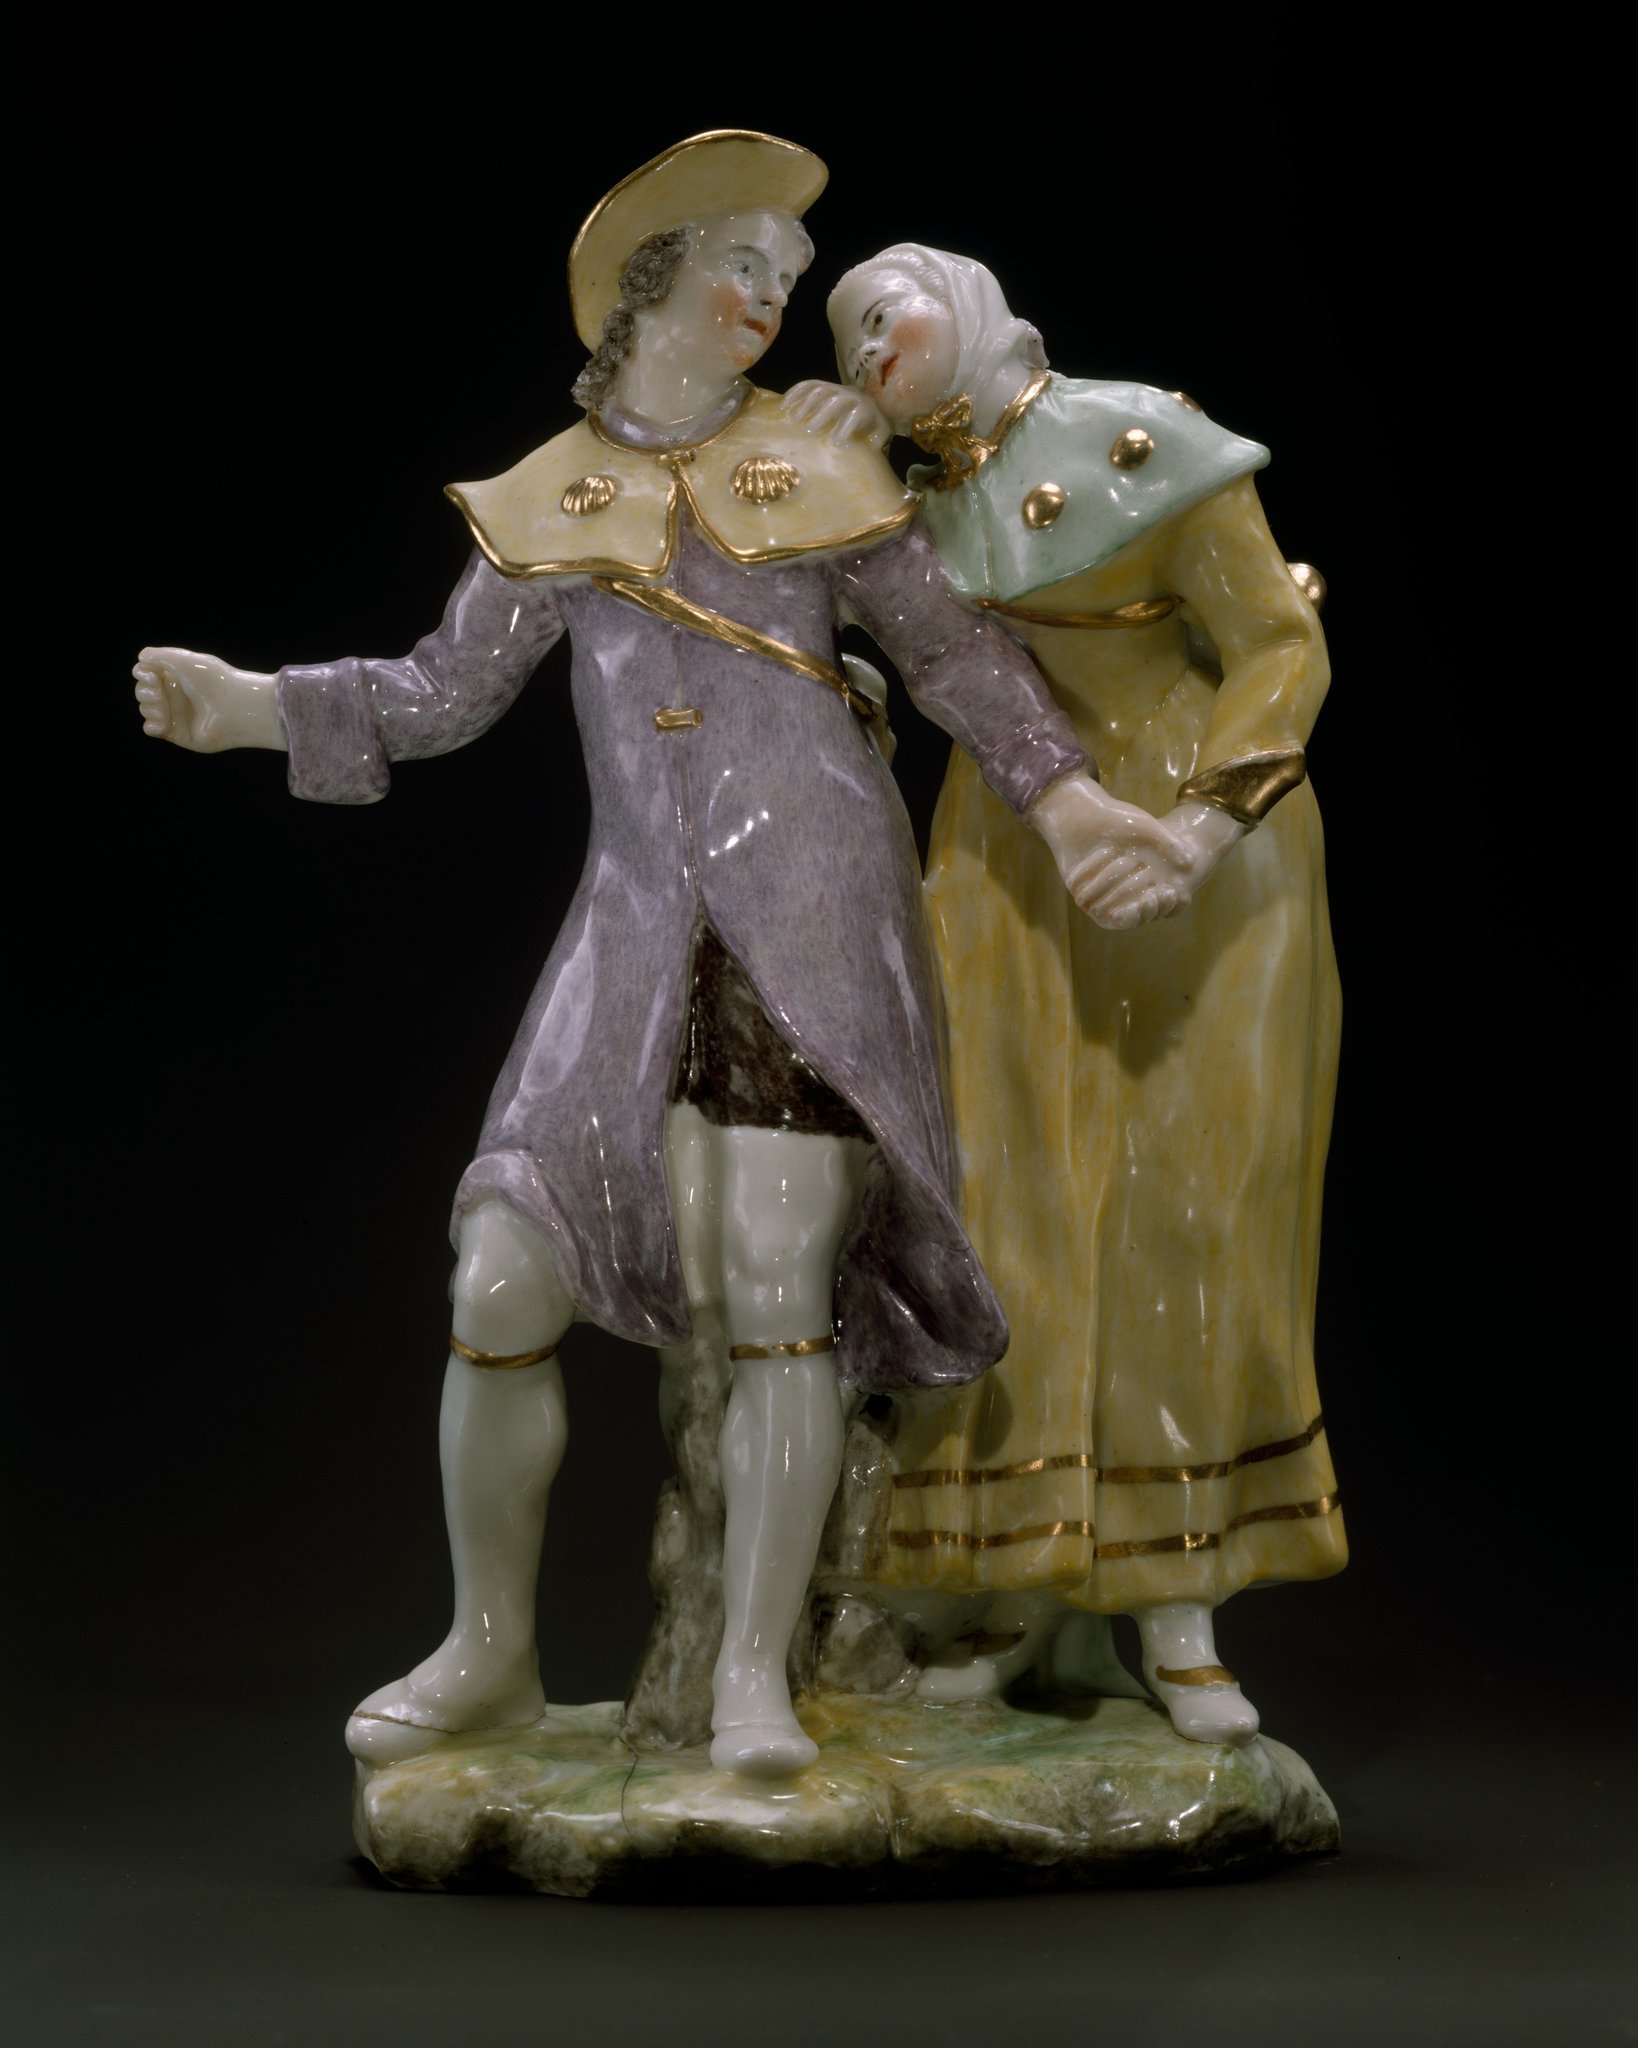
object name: group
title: Pilgrim Couple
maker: capodimonte porcelain manufactory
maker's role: manufactory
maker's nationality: italian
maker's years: 1740-1759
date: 1755-1759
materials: soft paste porcelain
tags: couples,men,women